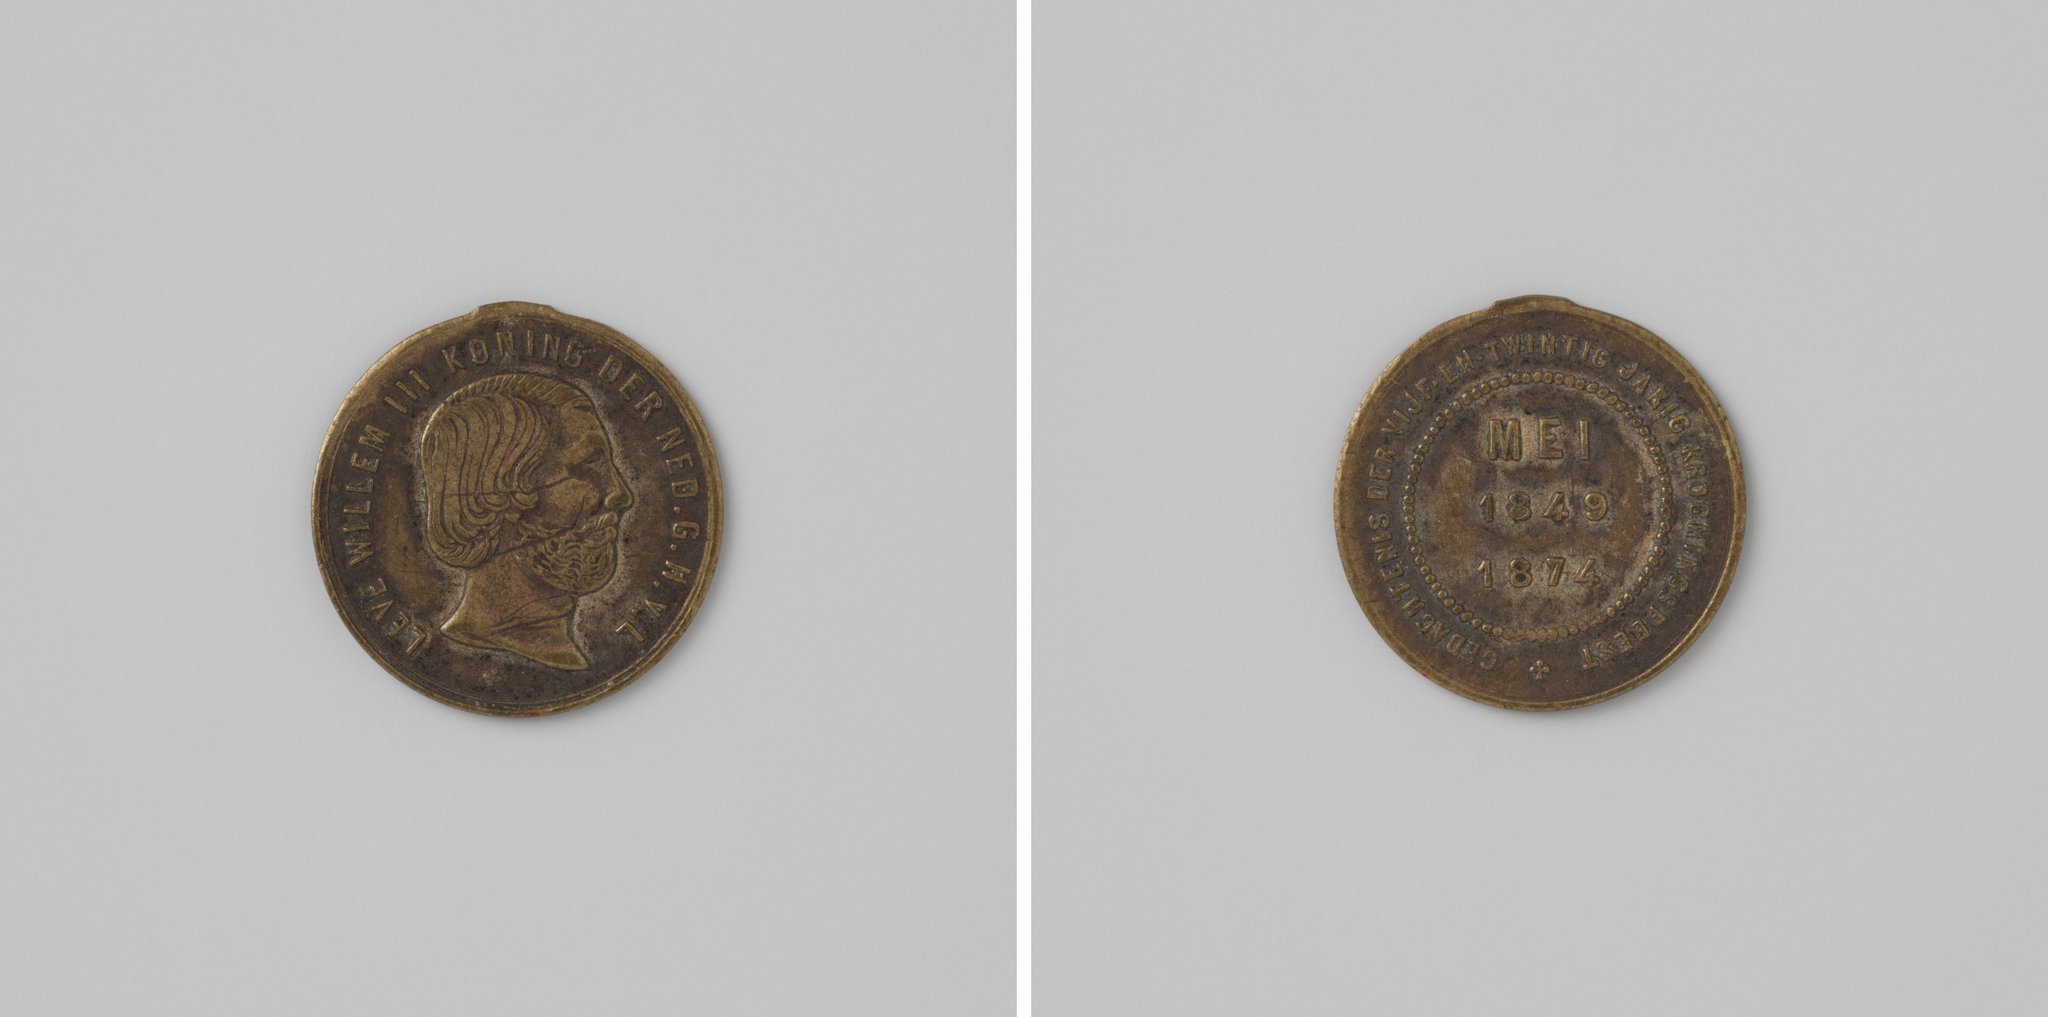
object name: history medal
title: Vijfentwintigjarig regeringsjubileum van Koning Willem III 1874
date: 1874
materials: brass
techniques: striking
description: Klein verzilverd messing penninkje met verwijderd draagoog, op de voorzijde het portret van Willem III naar rechts met omschrift, op de keerzijde drie regels tekst met omschrift.